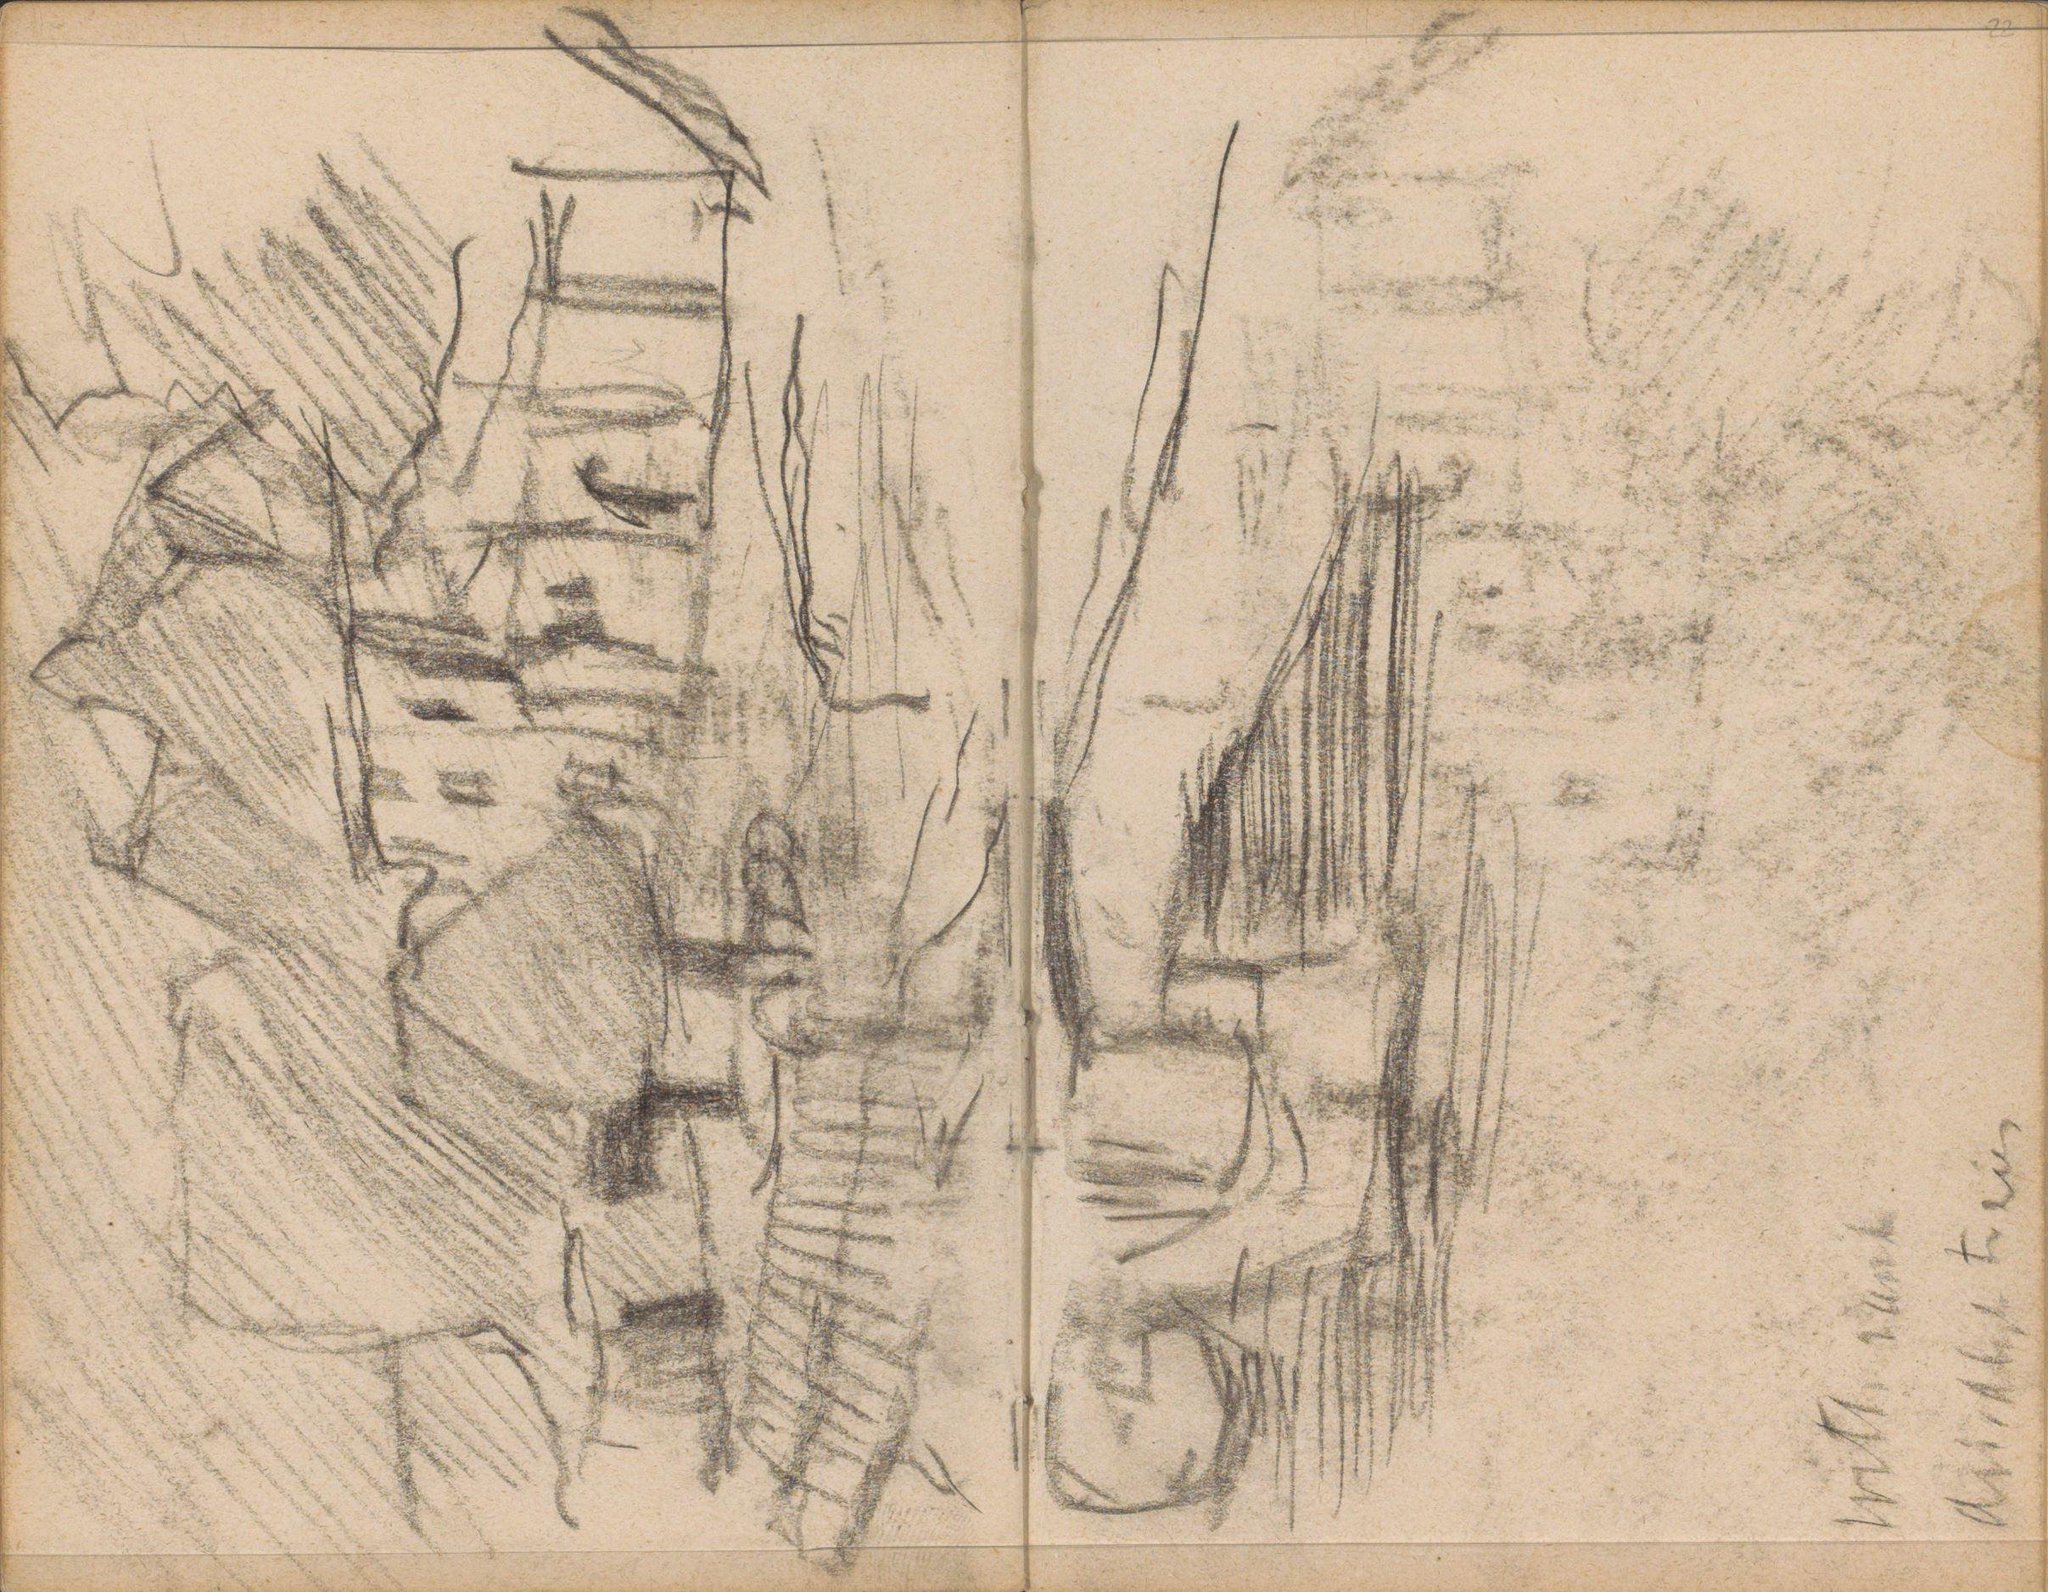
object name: sketchbook leaf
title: Nieuwe Teertuinen te Amsterdam, gezien vanaf de Sloterdijkerbrug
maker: george hendrik breitner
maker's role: draughtsman, painter, print maker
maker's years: 1857-1923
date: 1909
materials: chalk, paper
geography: amsterdam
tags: exterior of industrial structures, factories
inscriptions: annotation: ‘witte rand[?]/ duidlijk te zien’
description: Nieuwe Teertuinen te Amsterdam, gezien vanaf de Sloterdijkerbrug. Vooraan de kraan van de teerkokerij. Pagina 21 en pagina 22 uit een schetsboek met 45 bladen vervaardigd in Amsterdam en Pittsburgh.